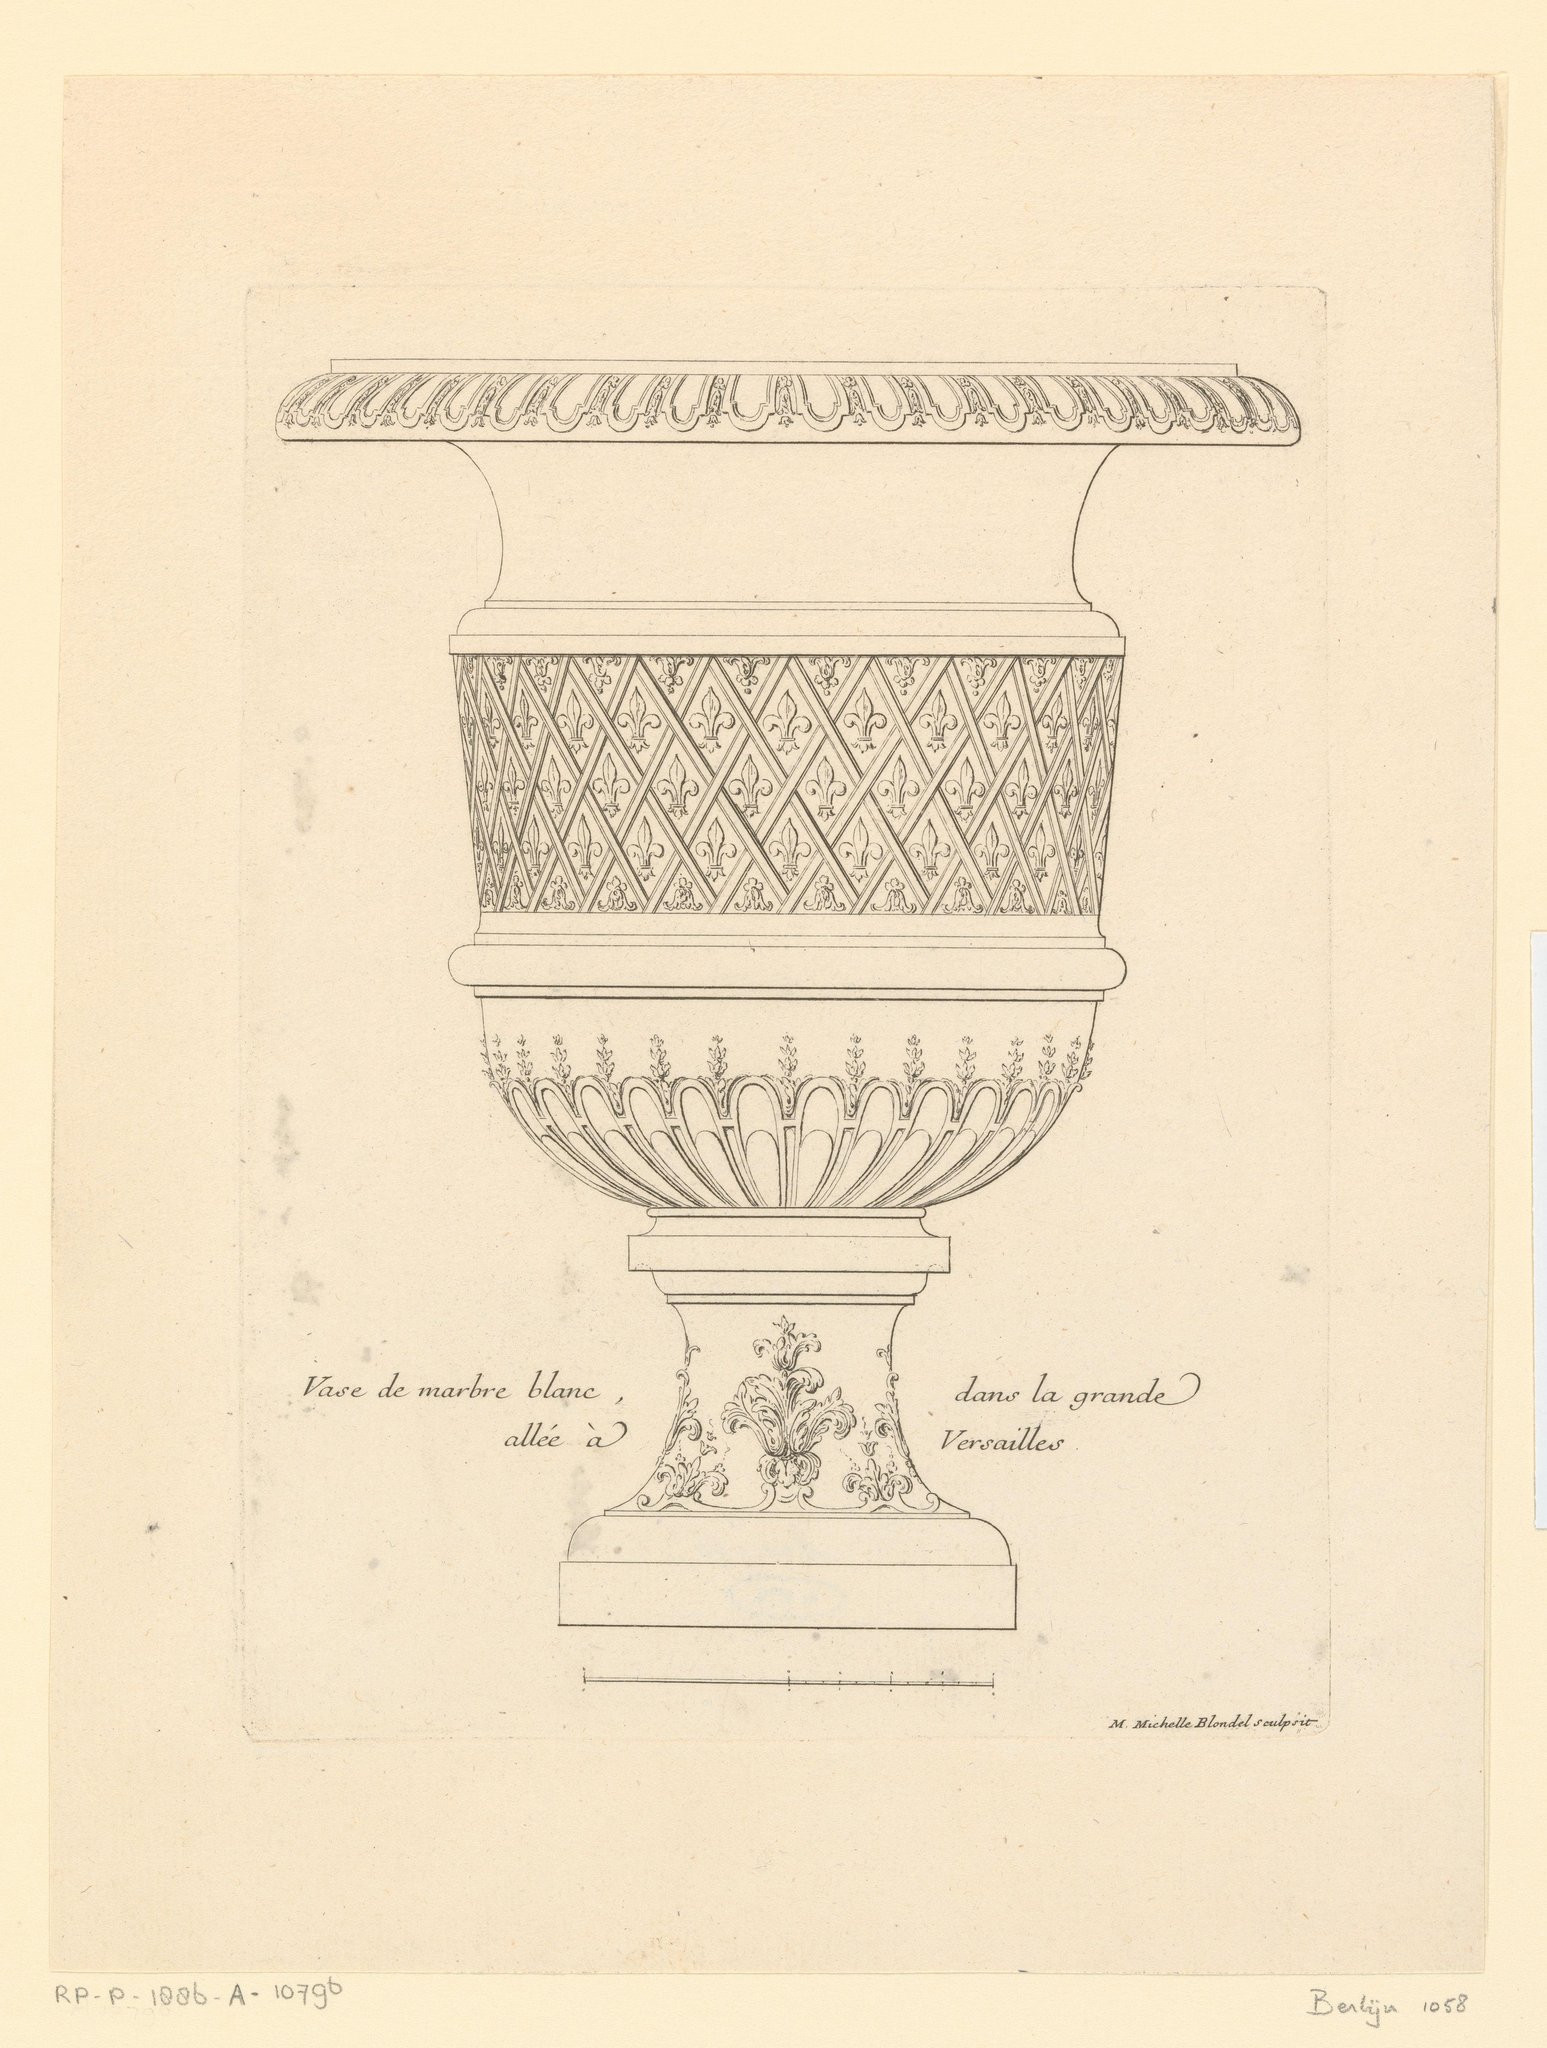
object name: ornament print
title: Siervazen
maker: marie michelle blondel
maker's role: print maker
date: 1723-1774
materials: paper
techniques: etching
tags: fleur-de-lis ~ ornament, garden vase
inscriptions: collector's mark: Lugt 2228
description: Een geornamenteerde siervaas met fleur-de-lis. Met tweeregelige Franse beschrijving.